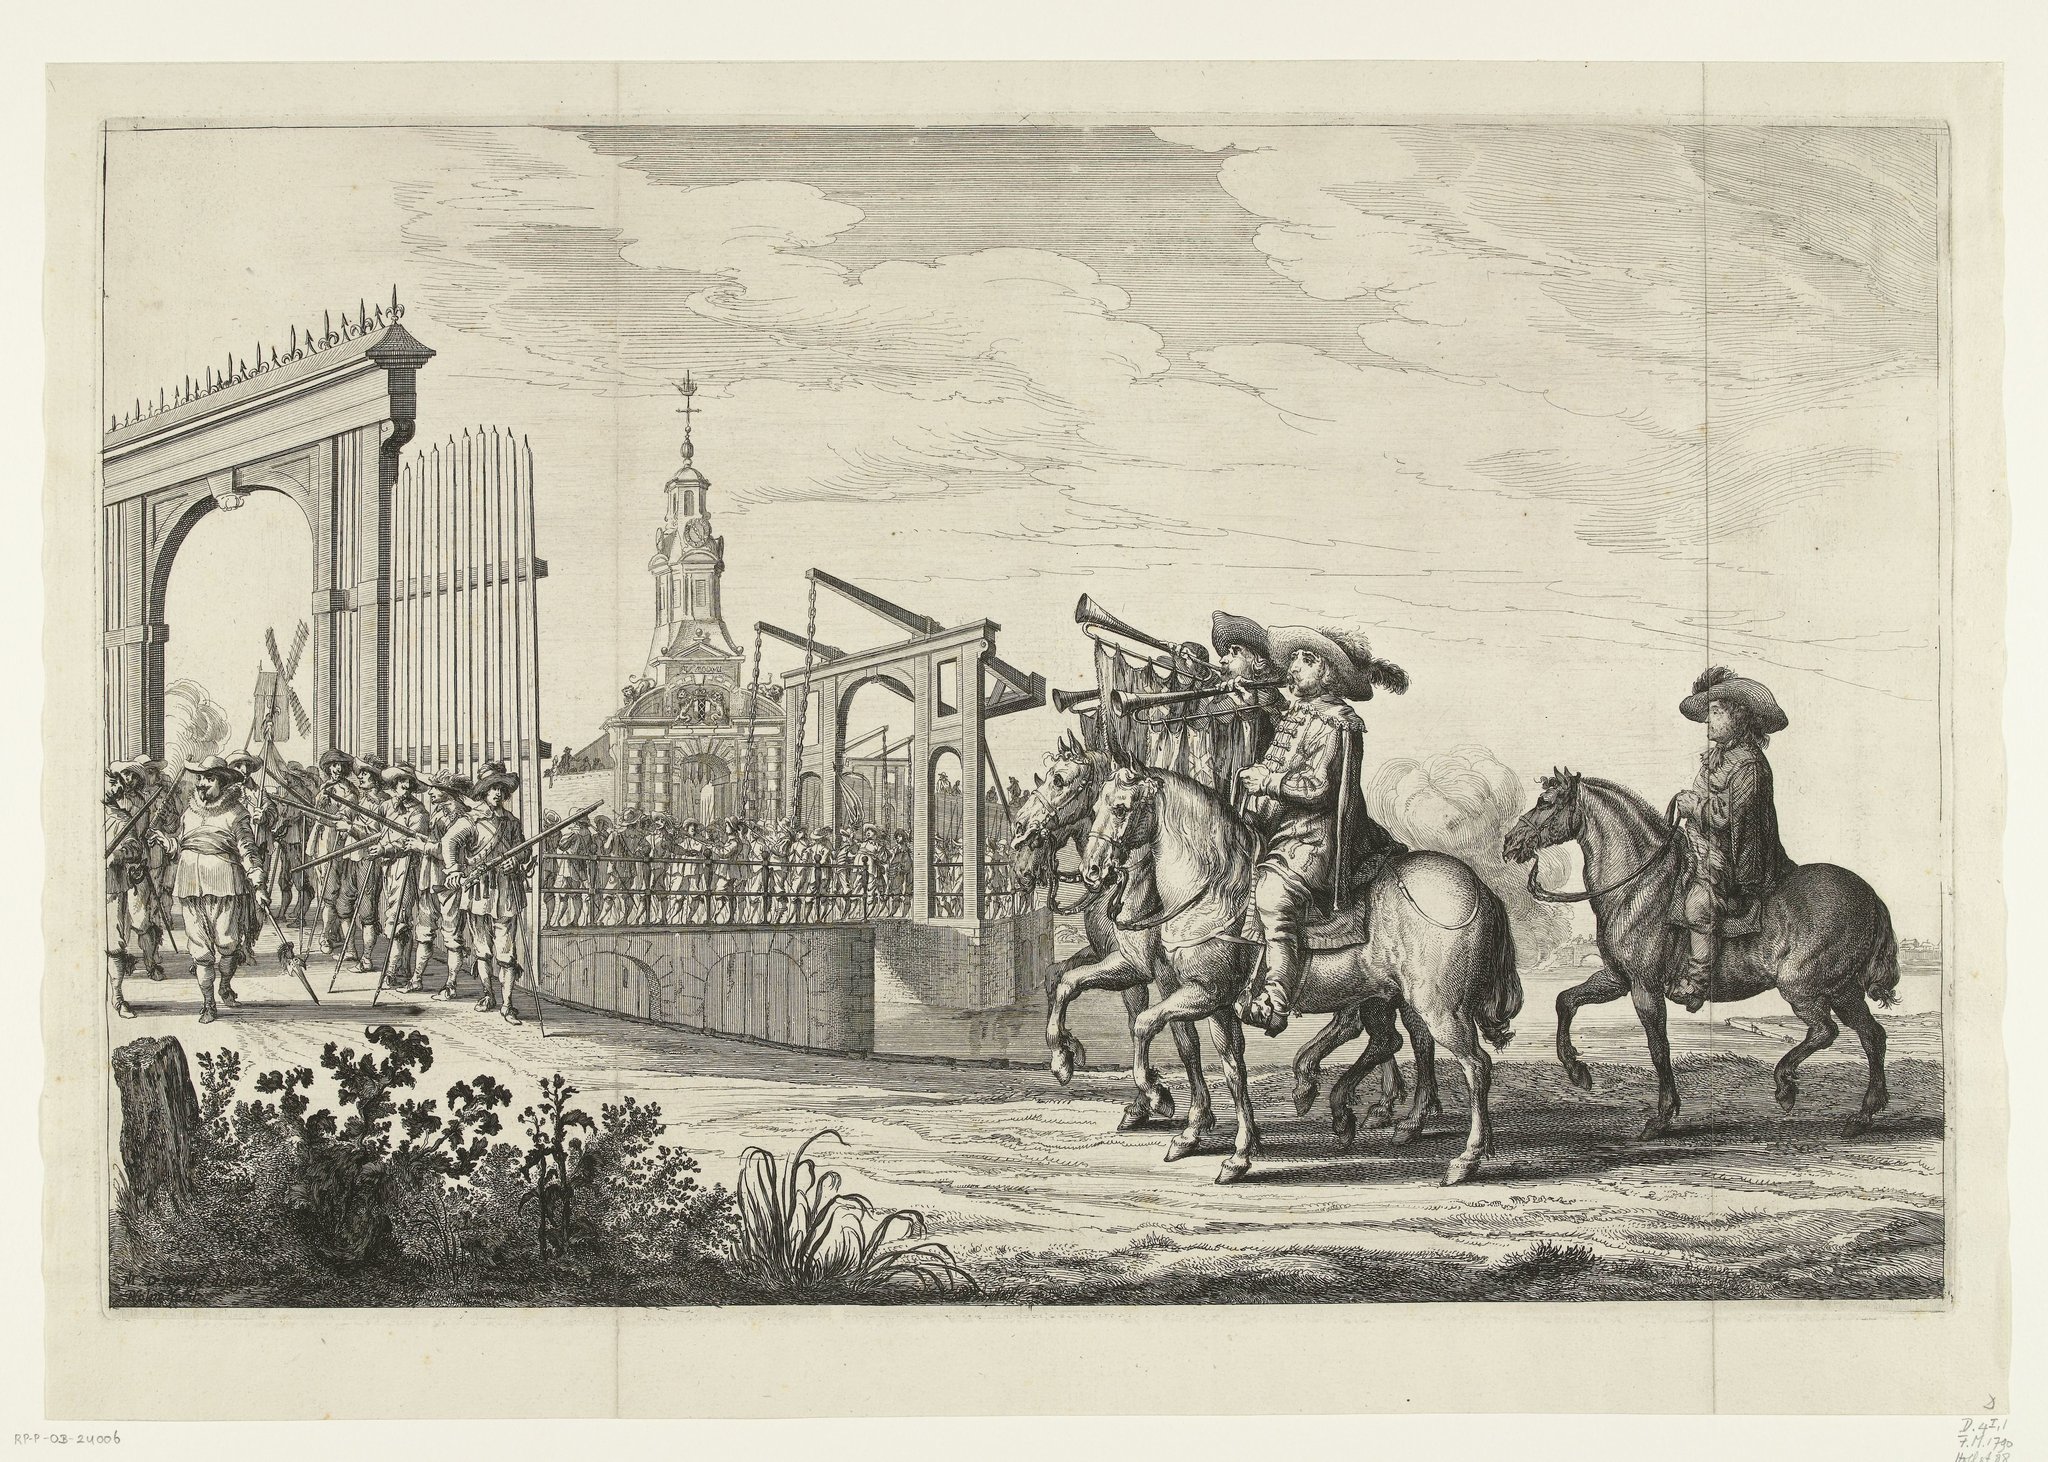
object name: print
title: Intocht van Maria de Médicis te Amsterdam (plaat 1), 1638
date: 1638-1639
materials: paper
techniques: engraving, etching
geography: northern netherlands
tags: cologne, maria de' medici, triumphal entry and public reception, pageant, 'entrée solennelle', 'joyeuse entrée'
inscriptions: collector's mark: Lugt 2228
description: Intocht van de Franse koningin Maria de Médicis te Amsterdam, 31 augustus 1638. Eerste plaat in een ongemonteerd ensemble bestaande uit een titelblad, een portret en zeven bladen van de stoet. De aankomst van de stoet bij de Haarlemmerpoort, voorop drie trompetters.